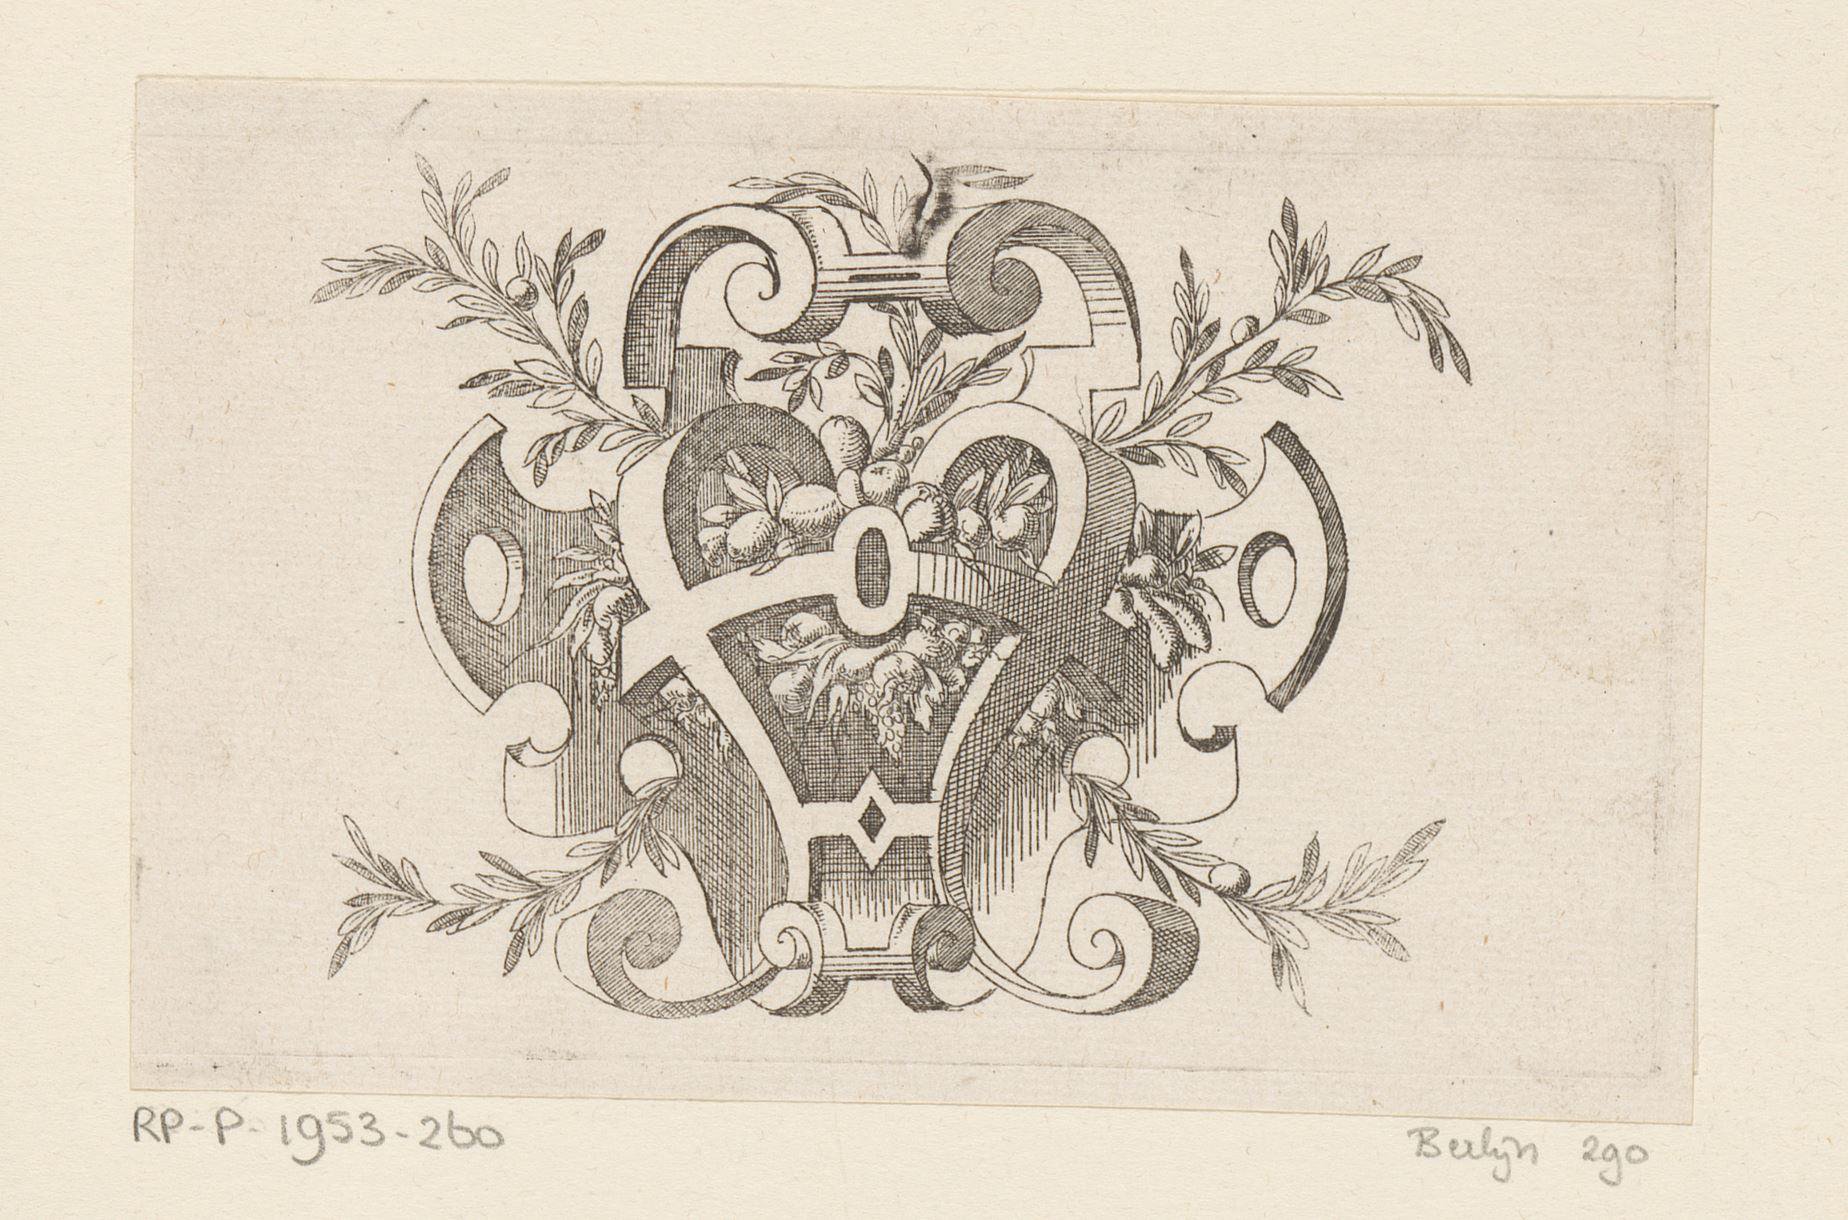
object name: print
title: Rolwerk met fruit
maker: jacques androuet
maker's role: draughtsman, print maker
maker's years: 1515-1584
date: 1520-1584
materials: paper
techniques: etching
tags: fruits and vegetables ~ ornament, scrollwork, strapwork ~ ornament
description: Cartouche van rolwerk met een korf vol vruchten en vijf takken met bladeren.